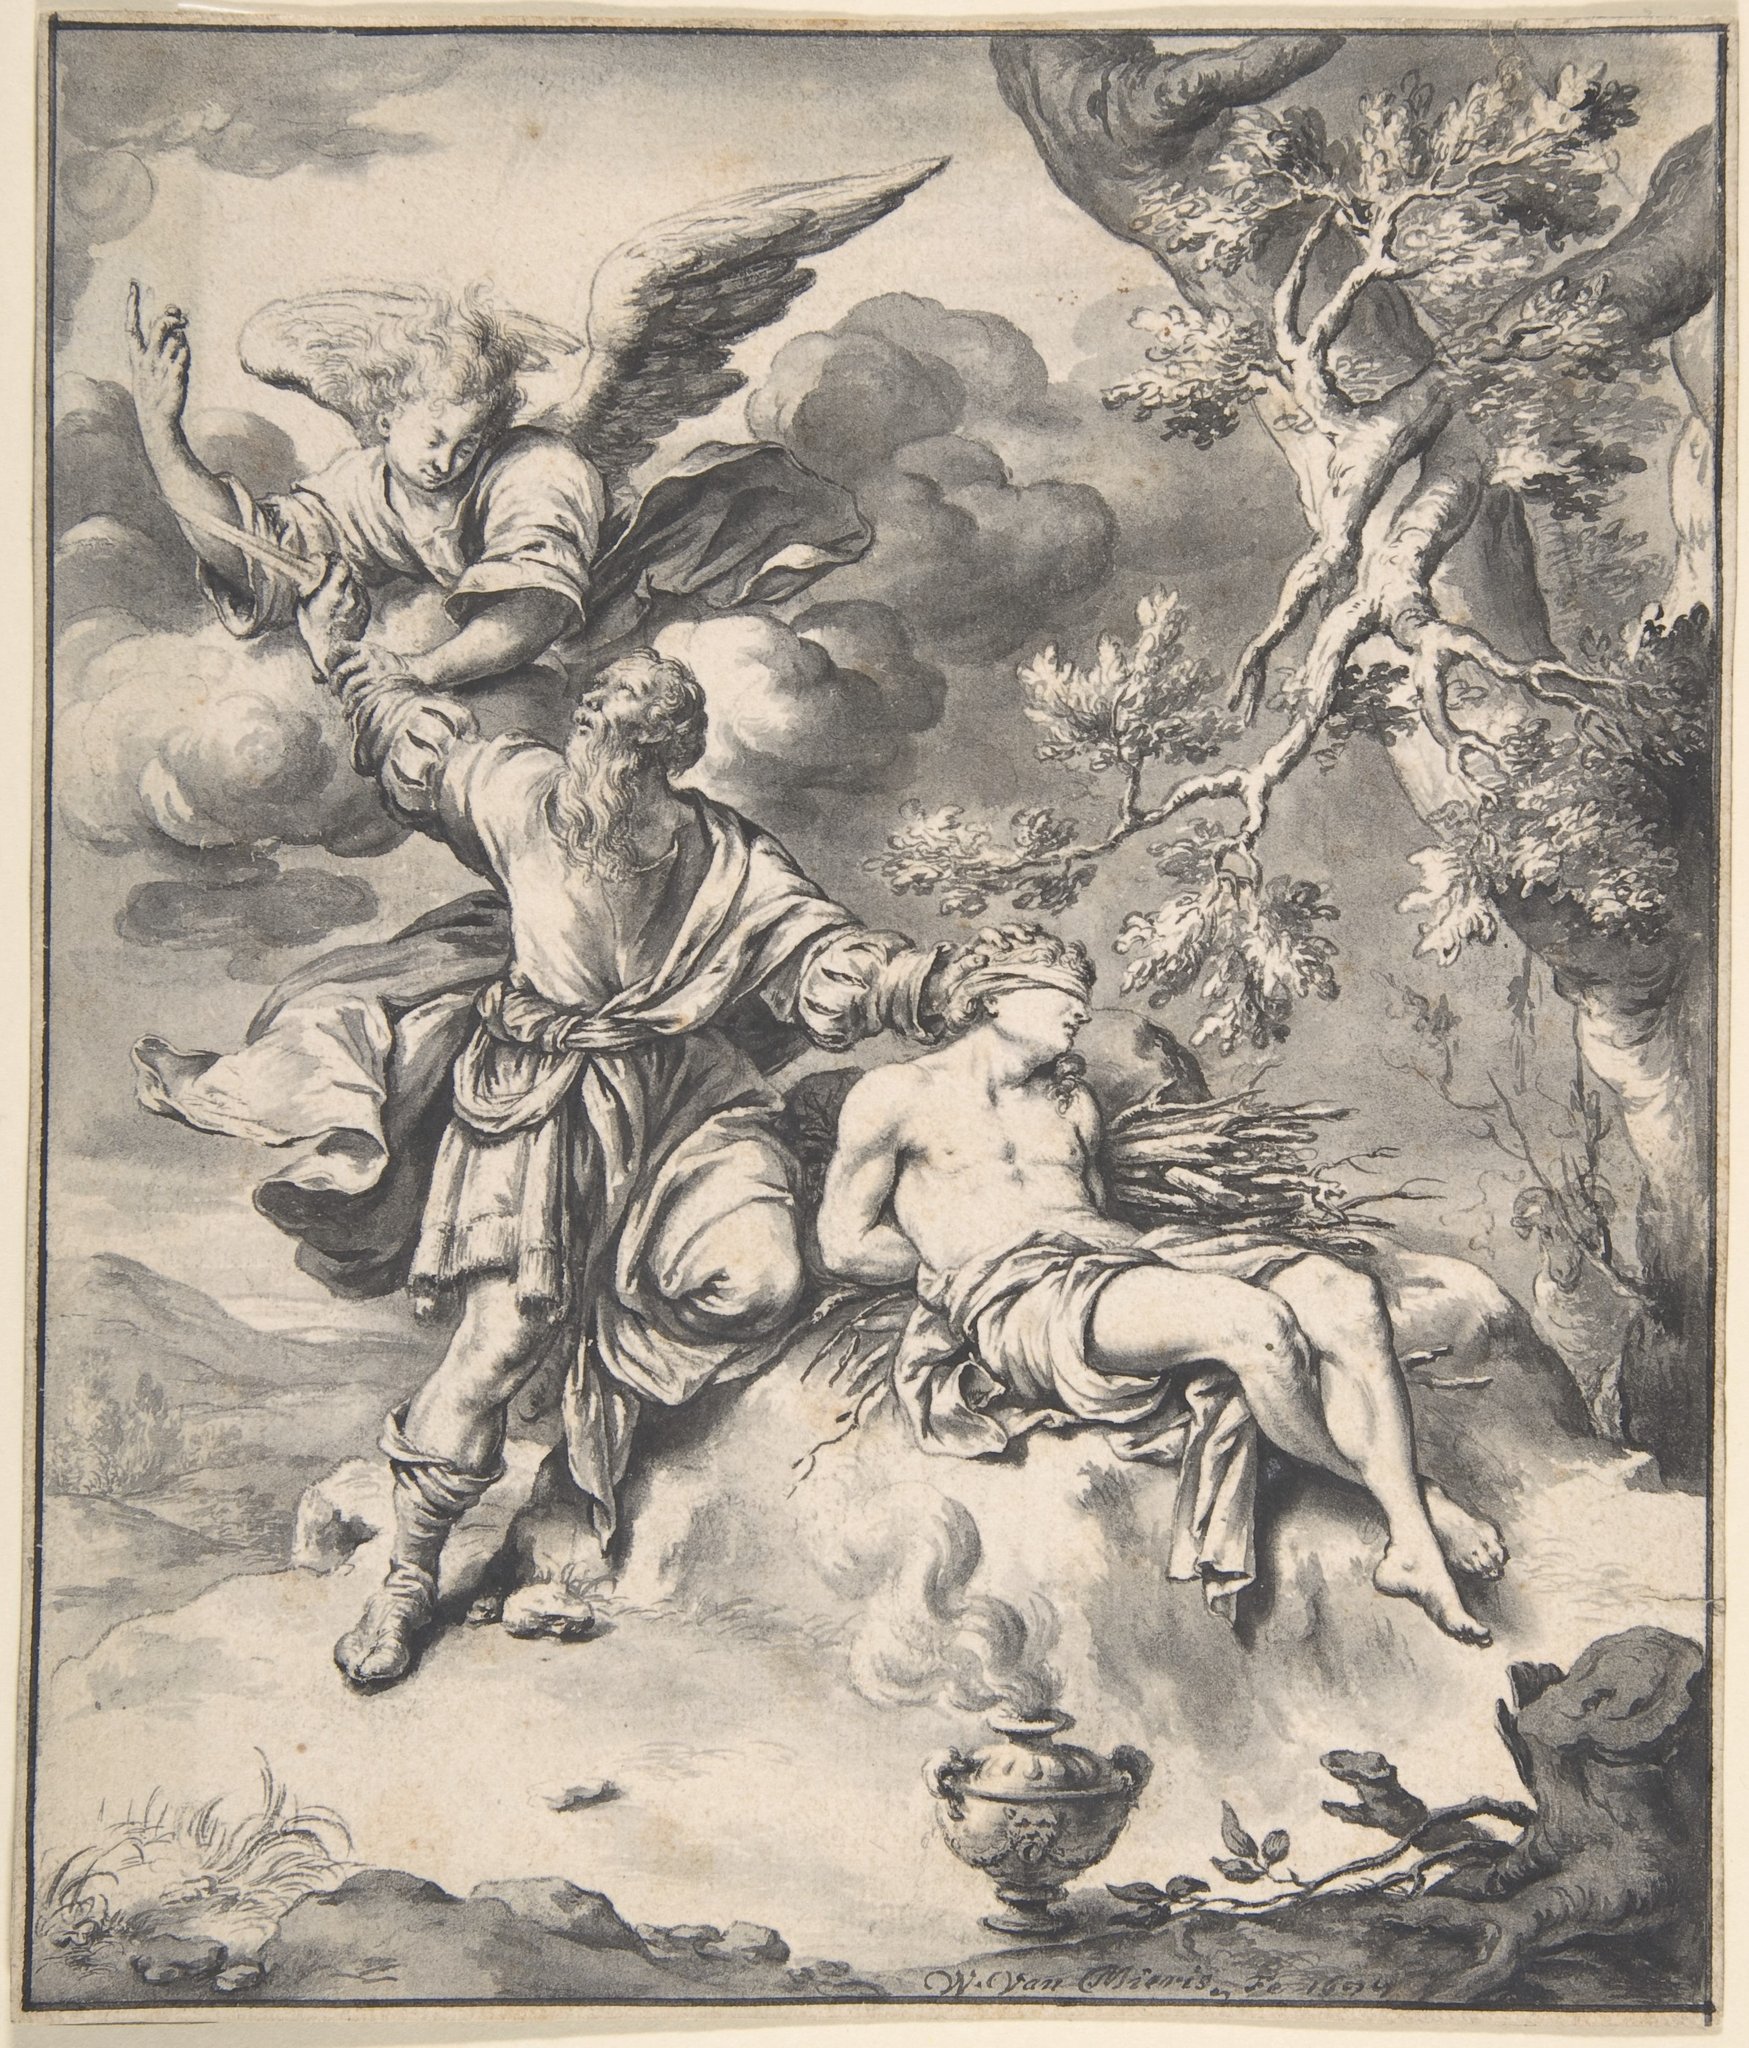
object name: drawing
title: The Sacrifice of Isaac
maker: willem van mieris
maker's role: artist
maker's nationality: dutch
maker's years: 1662-1747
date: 1694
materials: ink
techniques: brush, pen, wash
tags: men,angels,isaac